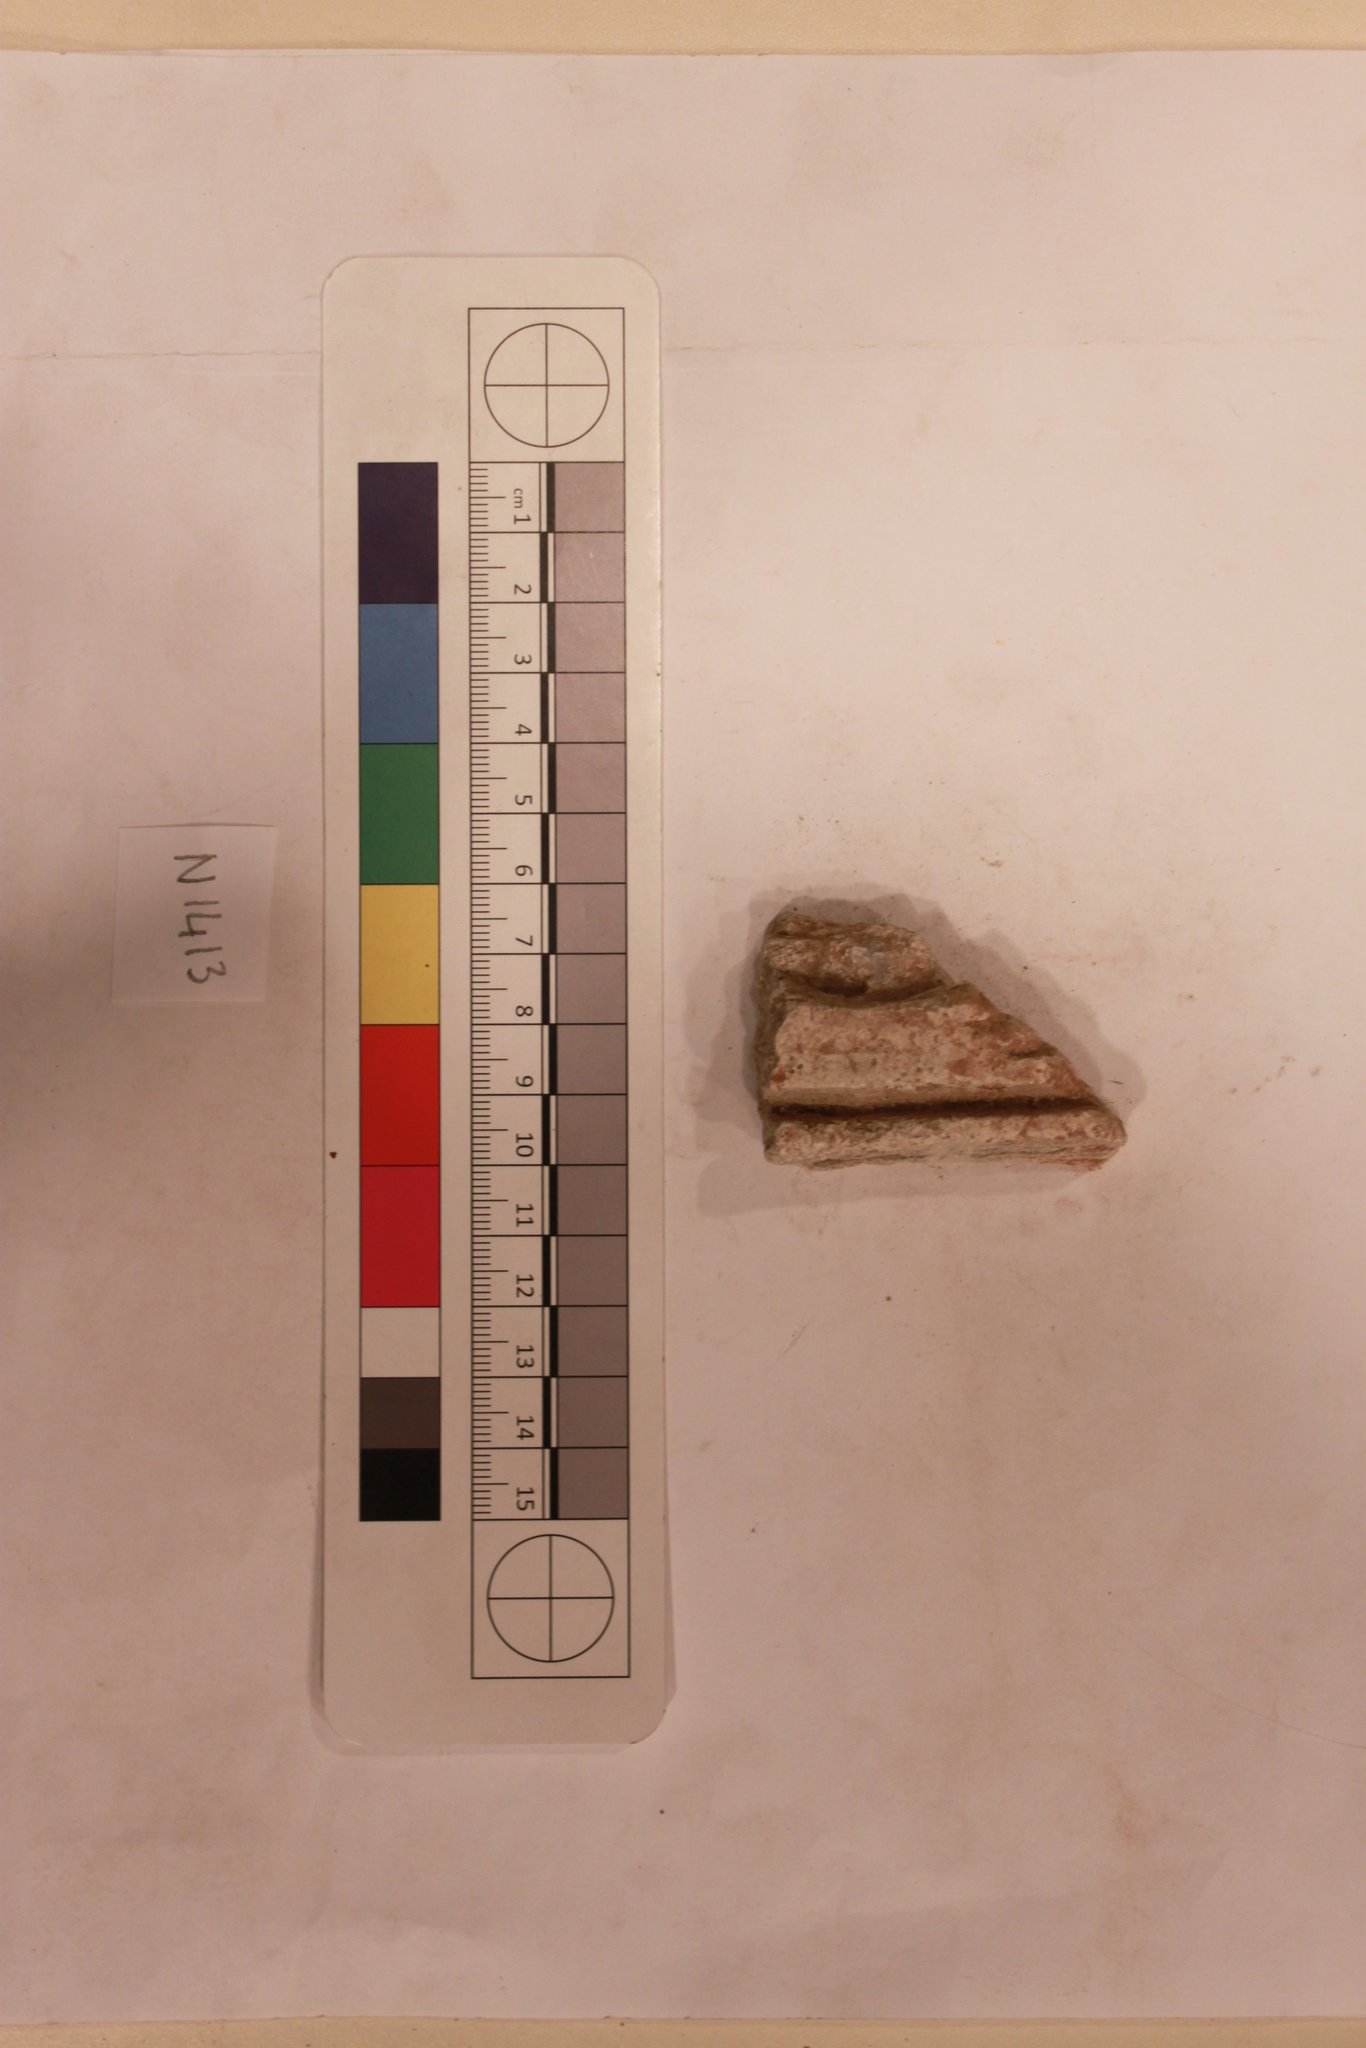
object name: fragment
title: Stucco Fragment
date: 701-1200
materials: plaster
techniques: carving, painting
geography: iran